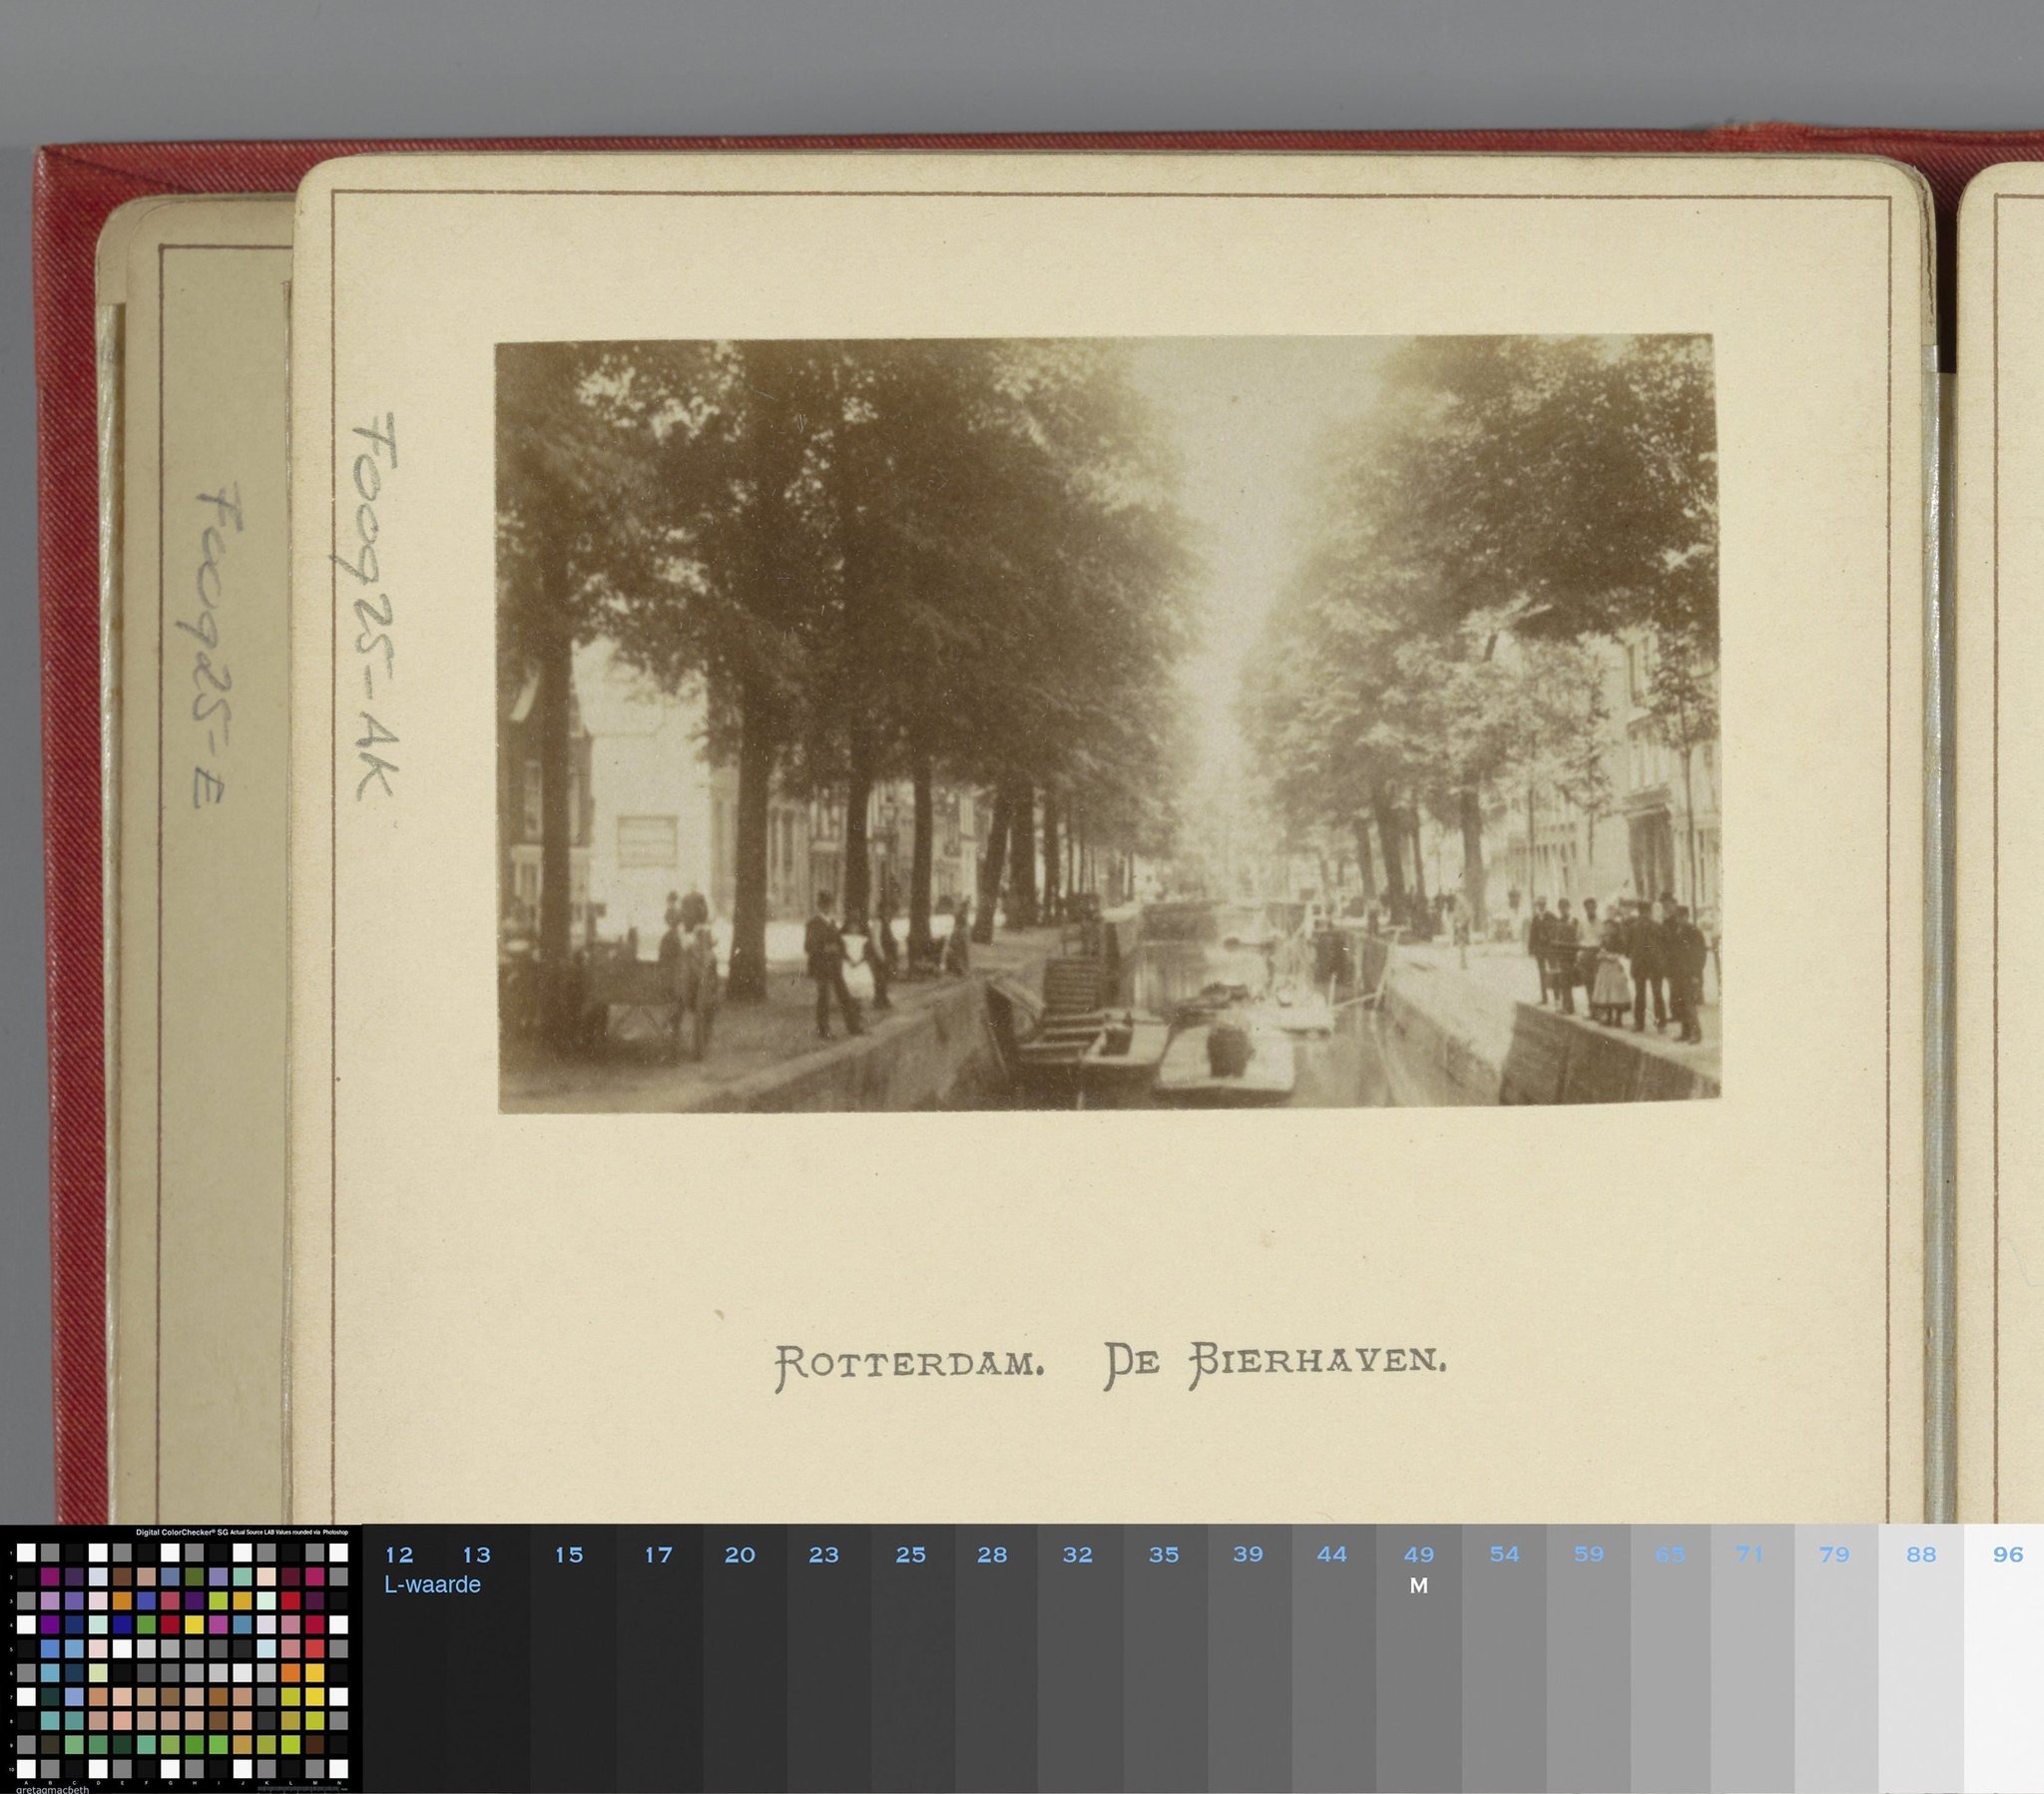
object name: album leaf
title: Rotterdam. De Bierhaven.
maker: andries jager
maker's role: publisher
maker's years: 1825-1905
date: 1860-1900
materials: cardboard, photographic support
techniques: albumen print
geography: rotterdam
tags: harbour (+ view ~ vehicle, ship, etc.), canal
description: Onderdeel van Fotoalbum met opnames van steden in Noord- en Zuid-Holland en Utrecht.